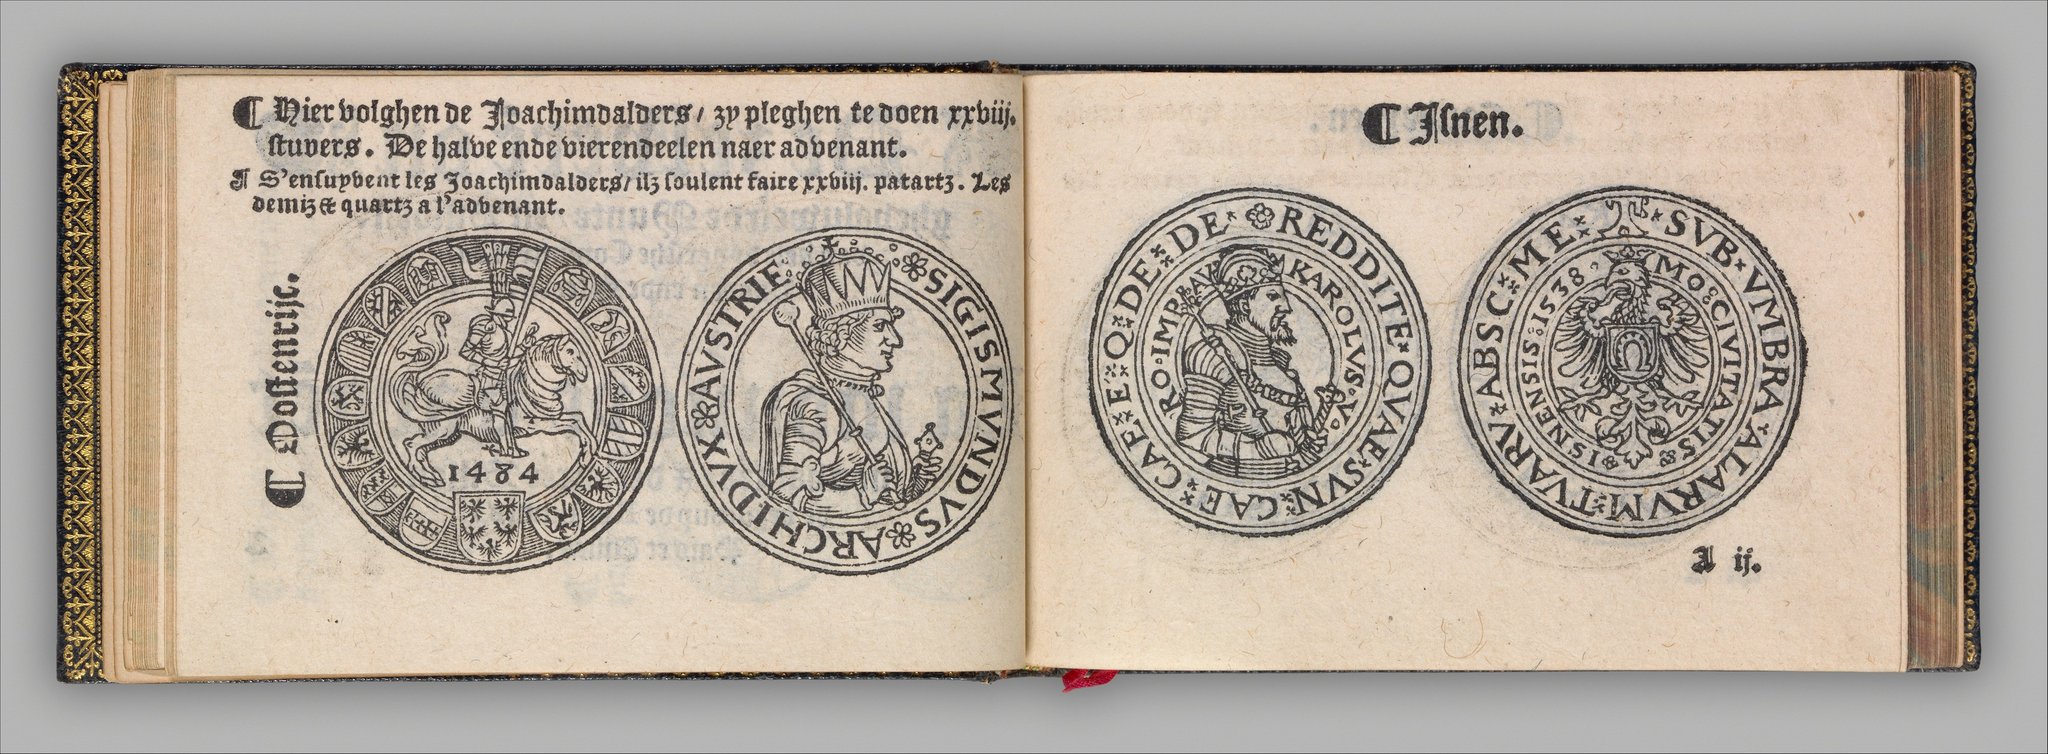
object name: book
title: Les Monnoyes d'or & d'argent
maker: josse lambert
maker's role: publisher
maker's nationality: netherlandish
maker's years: 1491-1556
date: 1544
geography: ghent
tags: men,profiles,horses,flags